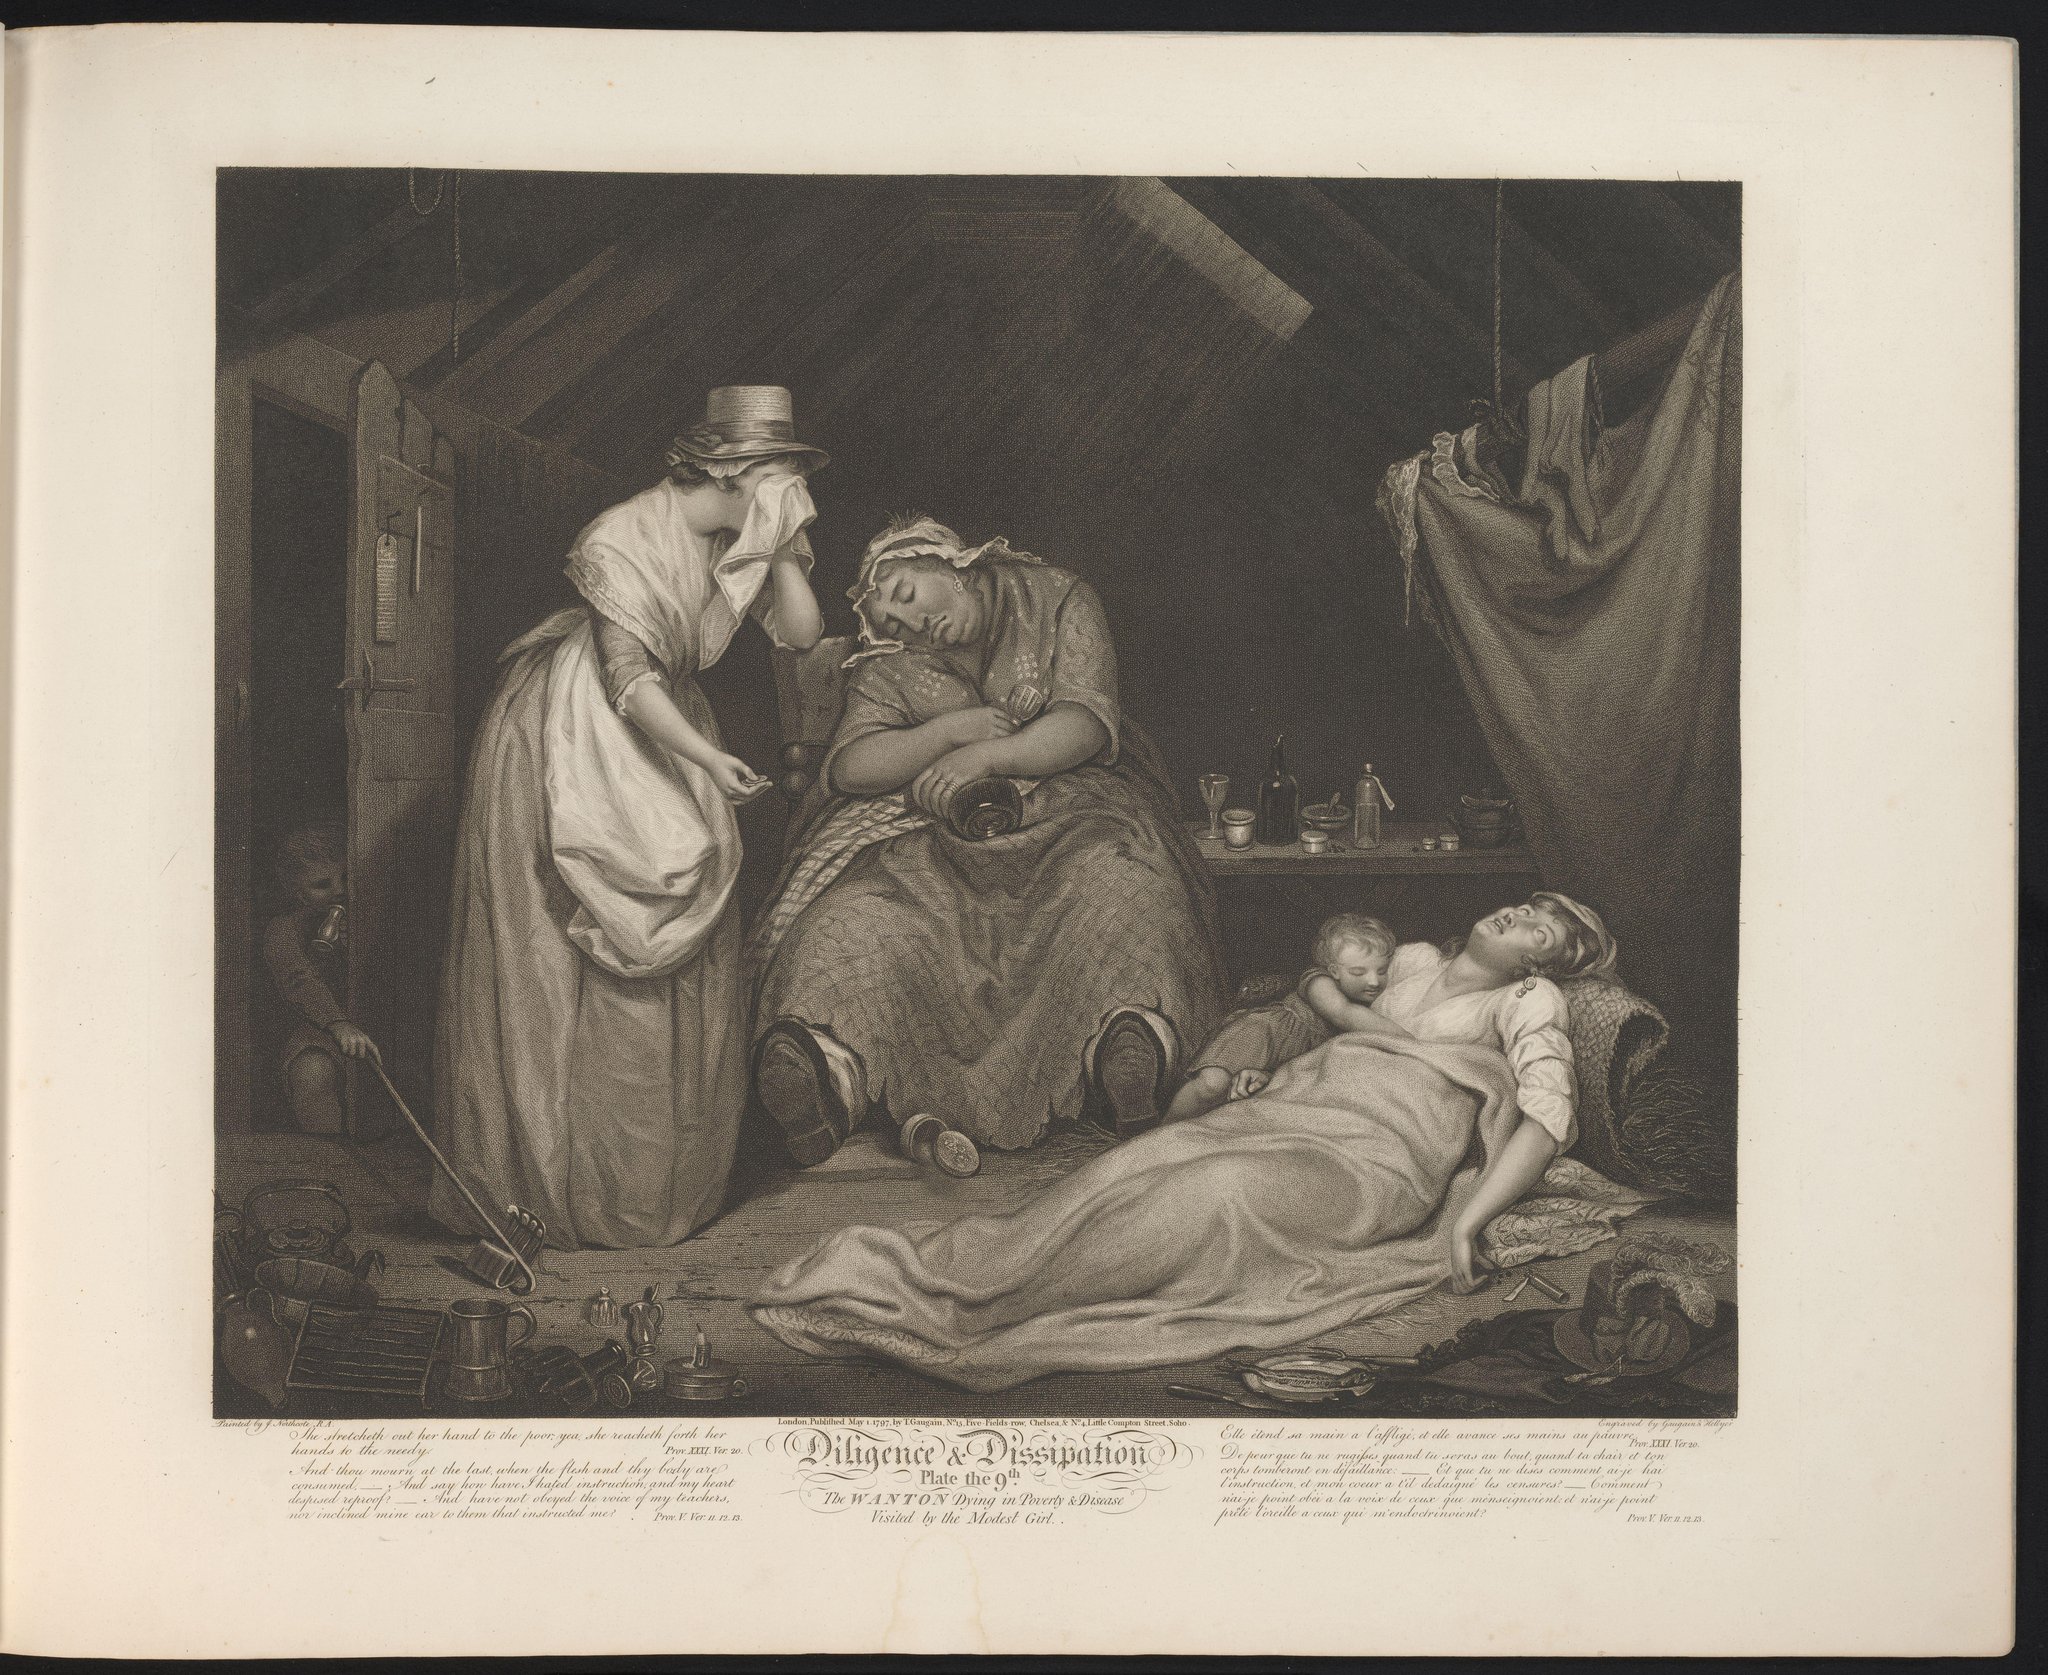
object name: print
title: Diligence & Dissipation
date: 1796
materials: paper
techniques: etching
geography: london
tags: good and bad behaviour, moral qualities (opposing concepts), chastity versus sensuality, good and bad behaviour, moral qualities, proverbs, sayings, etc., maid ~ house personnel, visiting the sick; sick person together with others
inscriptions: collector's mark: Lugt 2760, collector's mark: Lugt 2228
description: De goede dienstmaagd komt geld brengen aan de losbandige dienstmaagd die op sterven ligt met een kind aan haar borst. Het tafereel speelt zich af in een armoedige zolderkamer. Op de achtergrond zit een vrouw te slapen met een fles en een glas in haar handen. De prent maakt deel uit van een album.